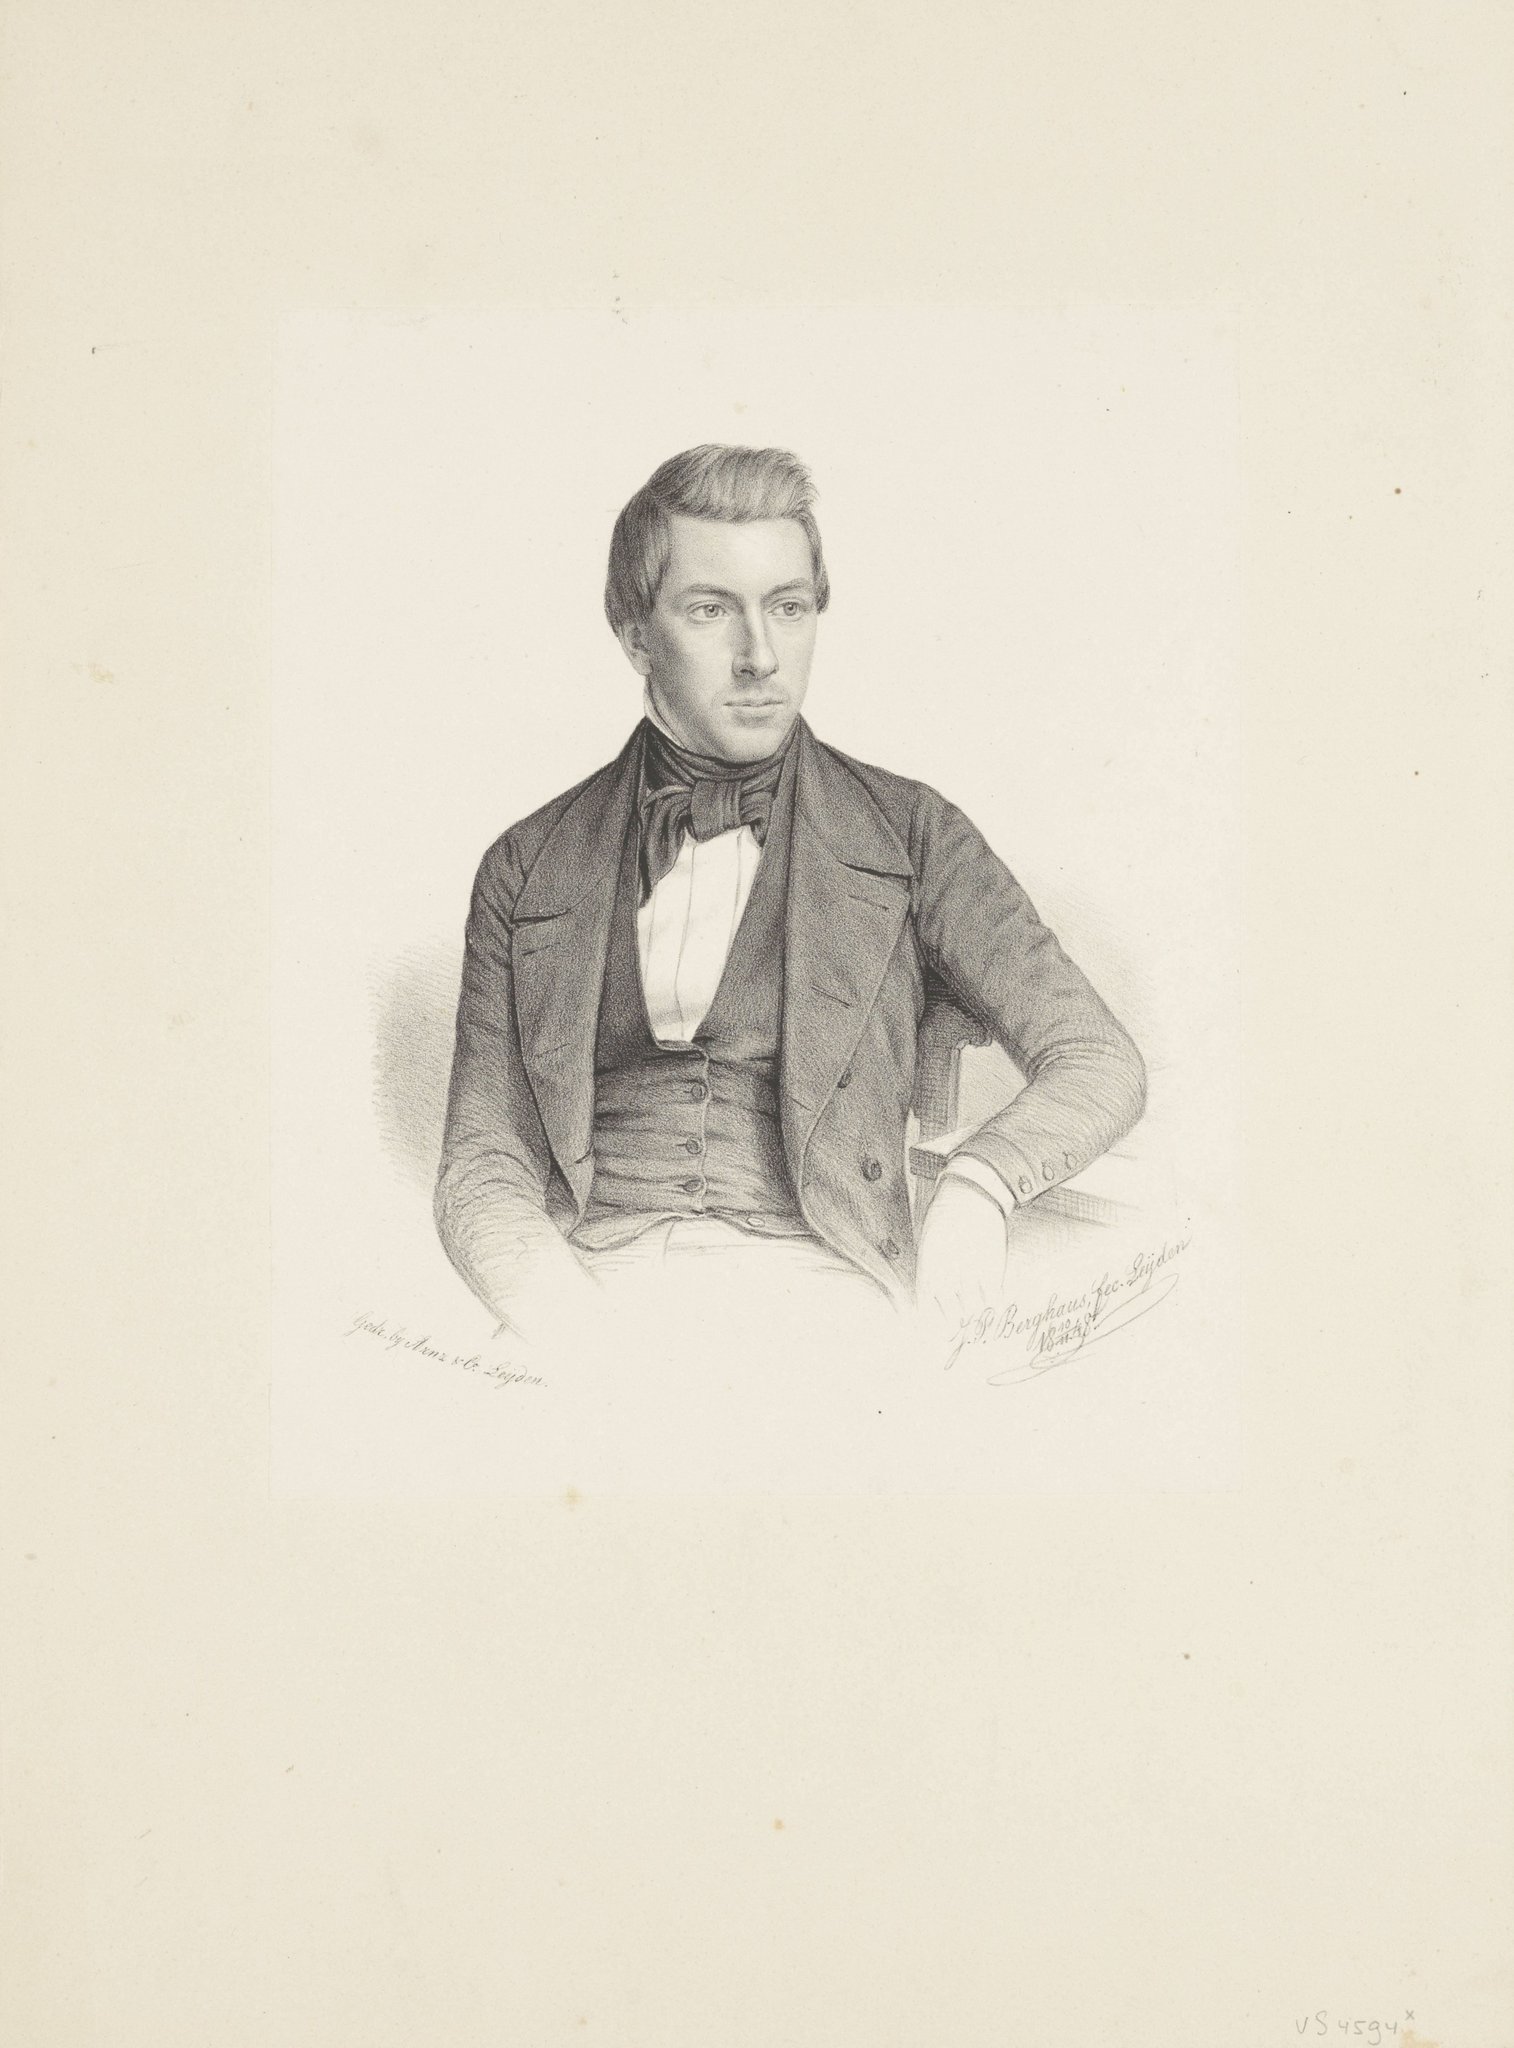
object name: print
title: Portret van Leonardus Johanna de Roock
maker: johann peter berghaus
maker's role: print maker, printer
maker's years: 1810-1870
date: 1848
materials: paper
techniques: lithograph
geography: leiden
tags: historical persons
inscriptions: collector's mark: Lugt 2228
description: De geportretteerde zit op een stoel naast een tafel. Met zijn linkerarm rust hij op het tafelbad.